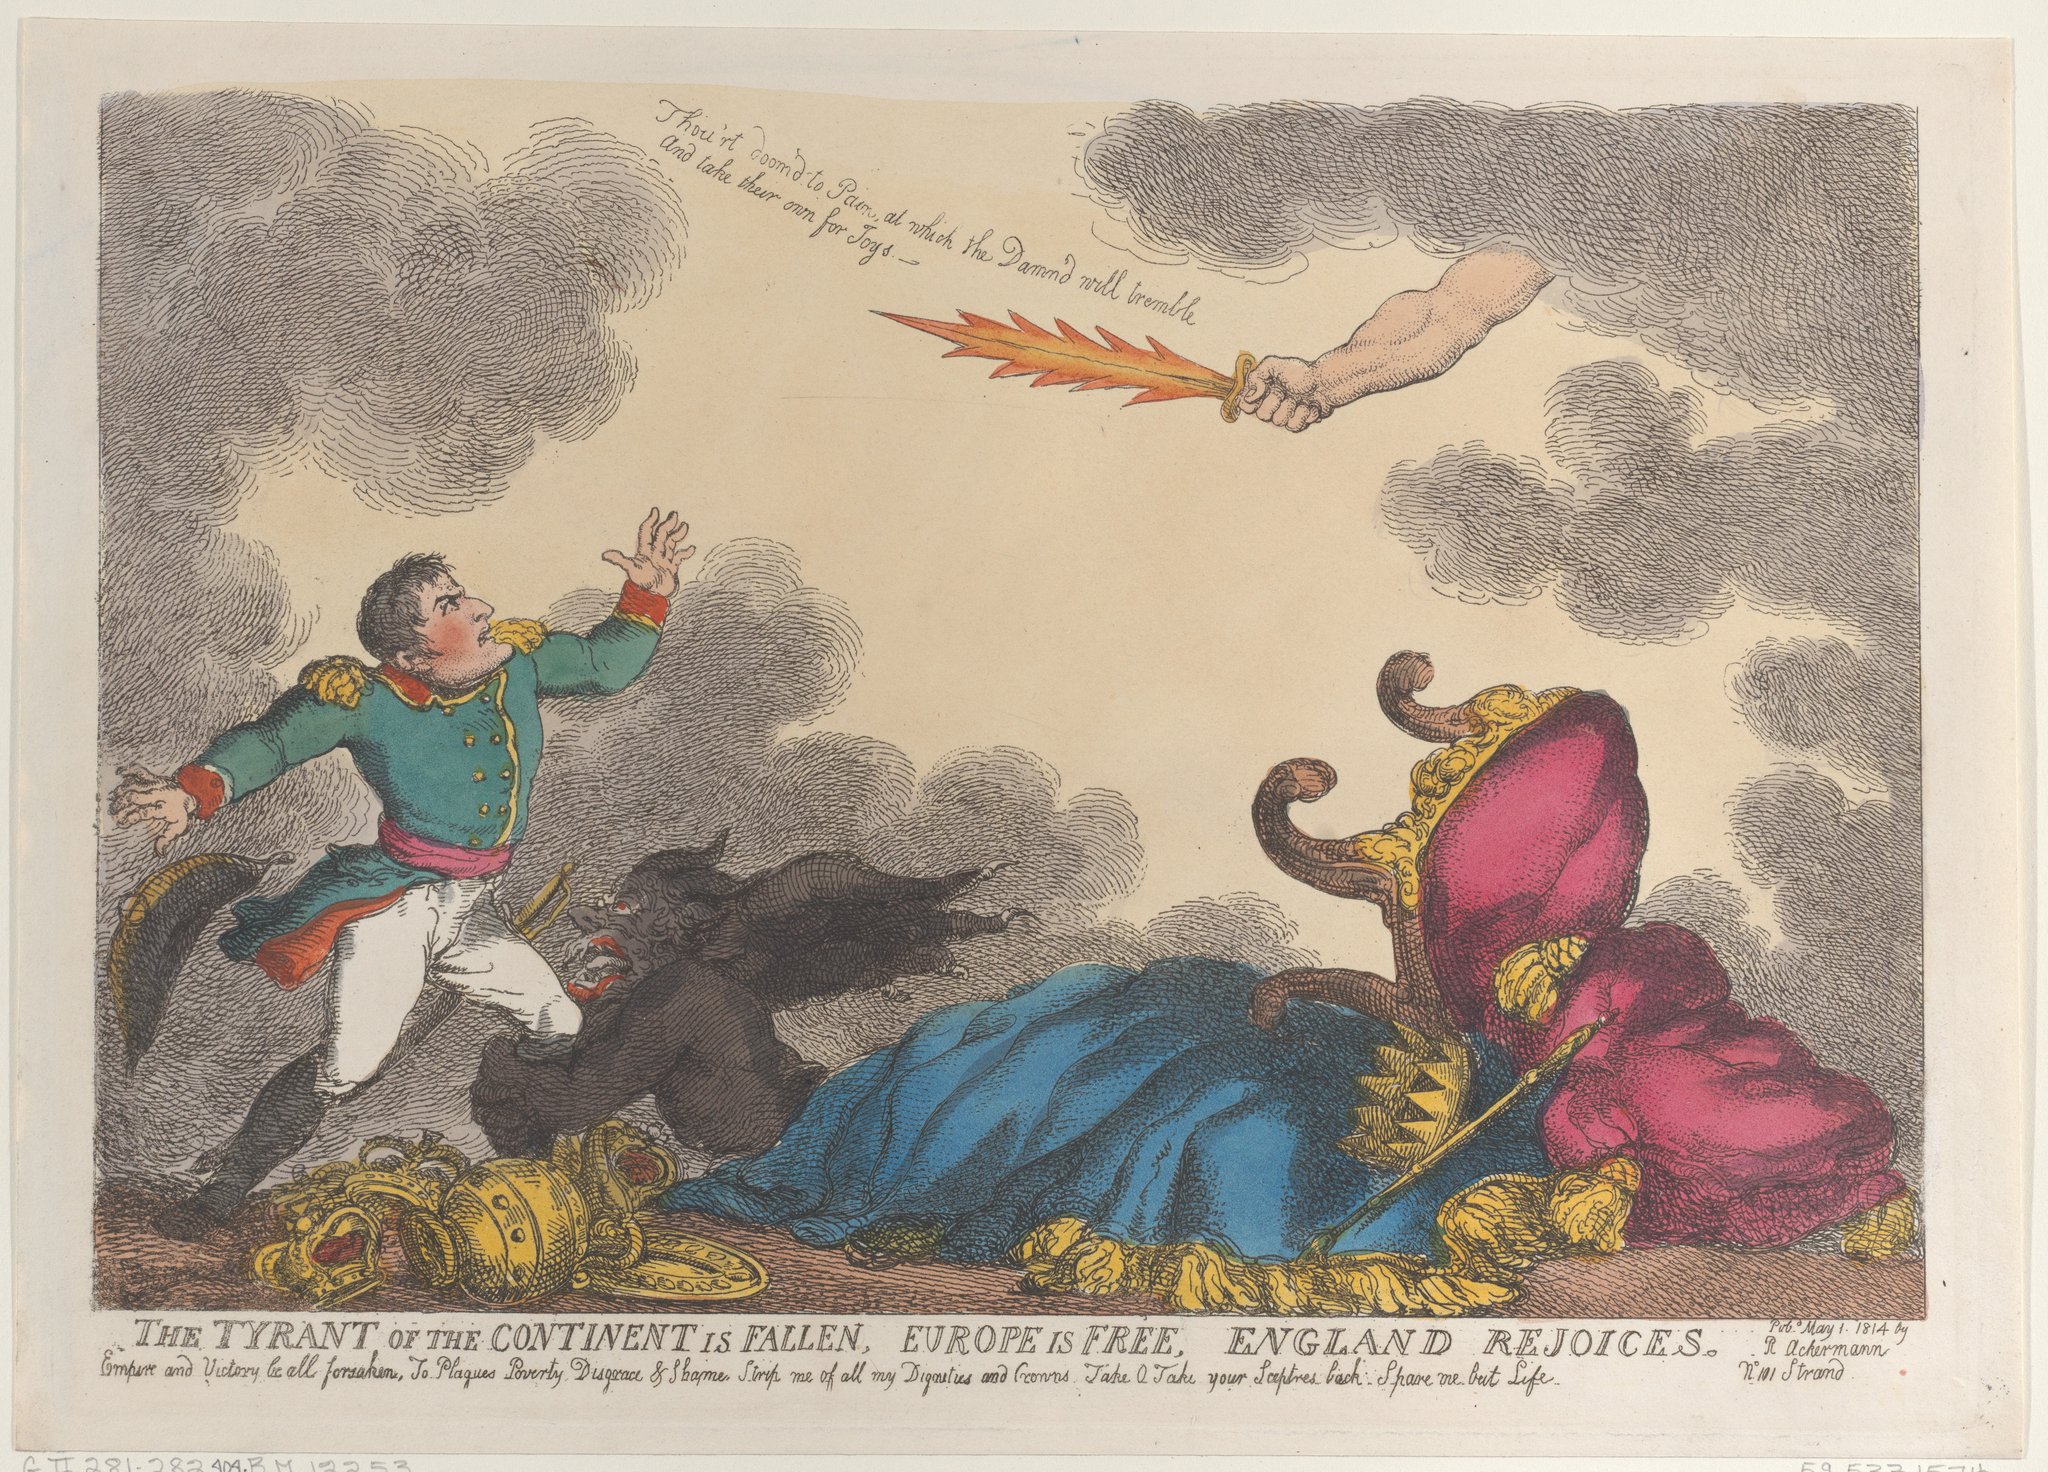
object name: print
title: The Tyrant of the Continent is Fallen, Europe is Free, England Rejoices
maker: thomas rowlandson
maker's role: artist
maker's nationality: british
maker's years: 1757-1827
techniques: etching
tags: satire,napoleon i,devil,politics